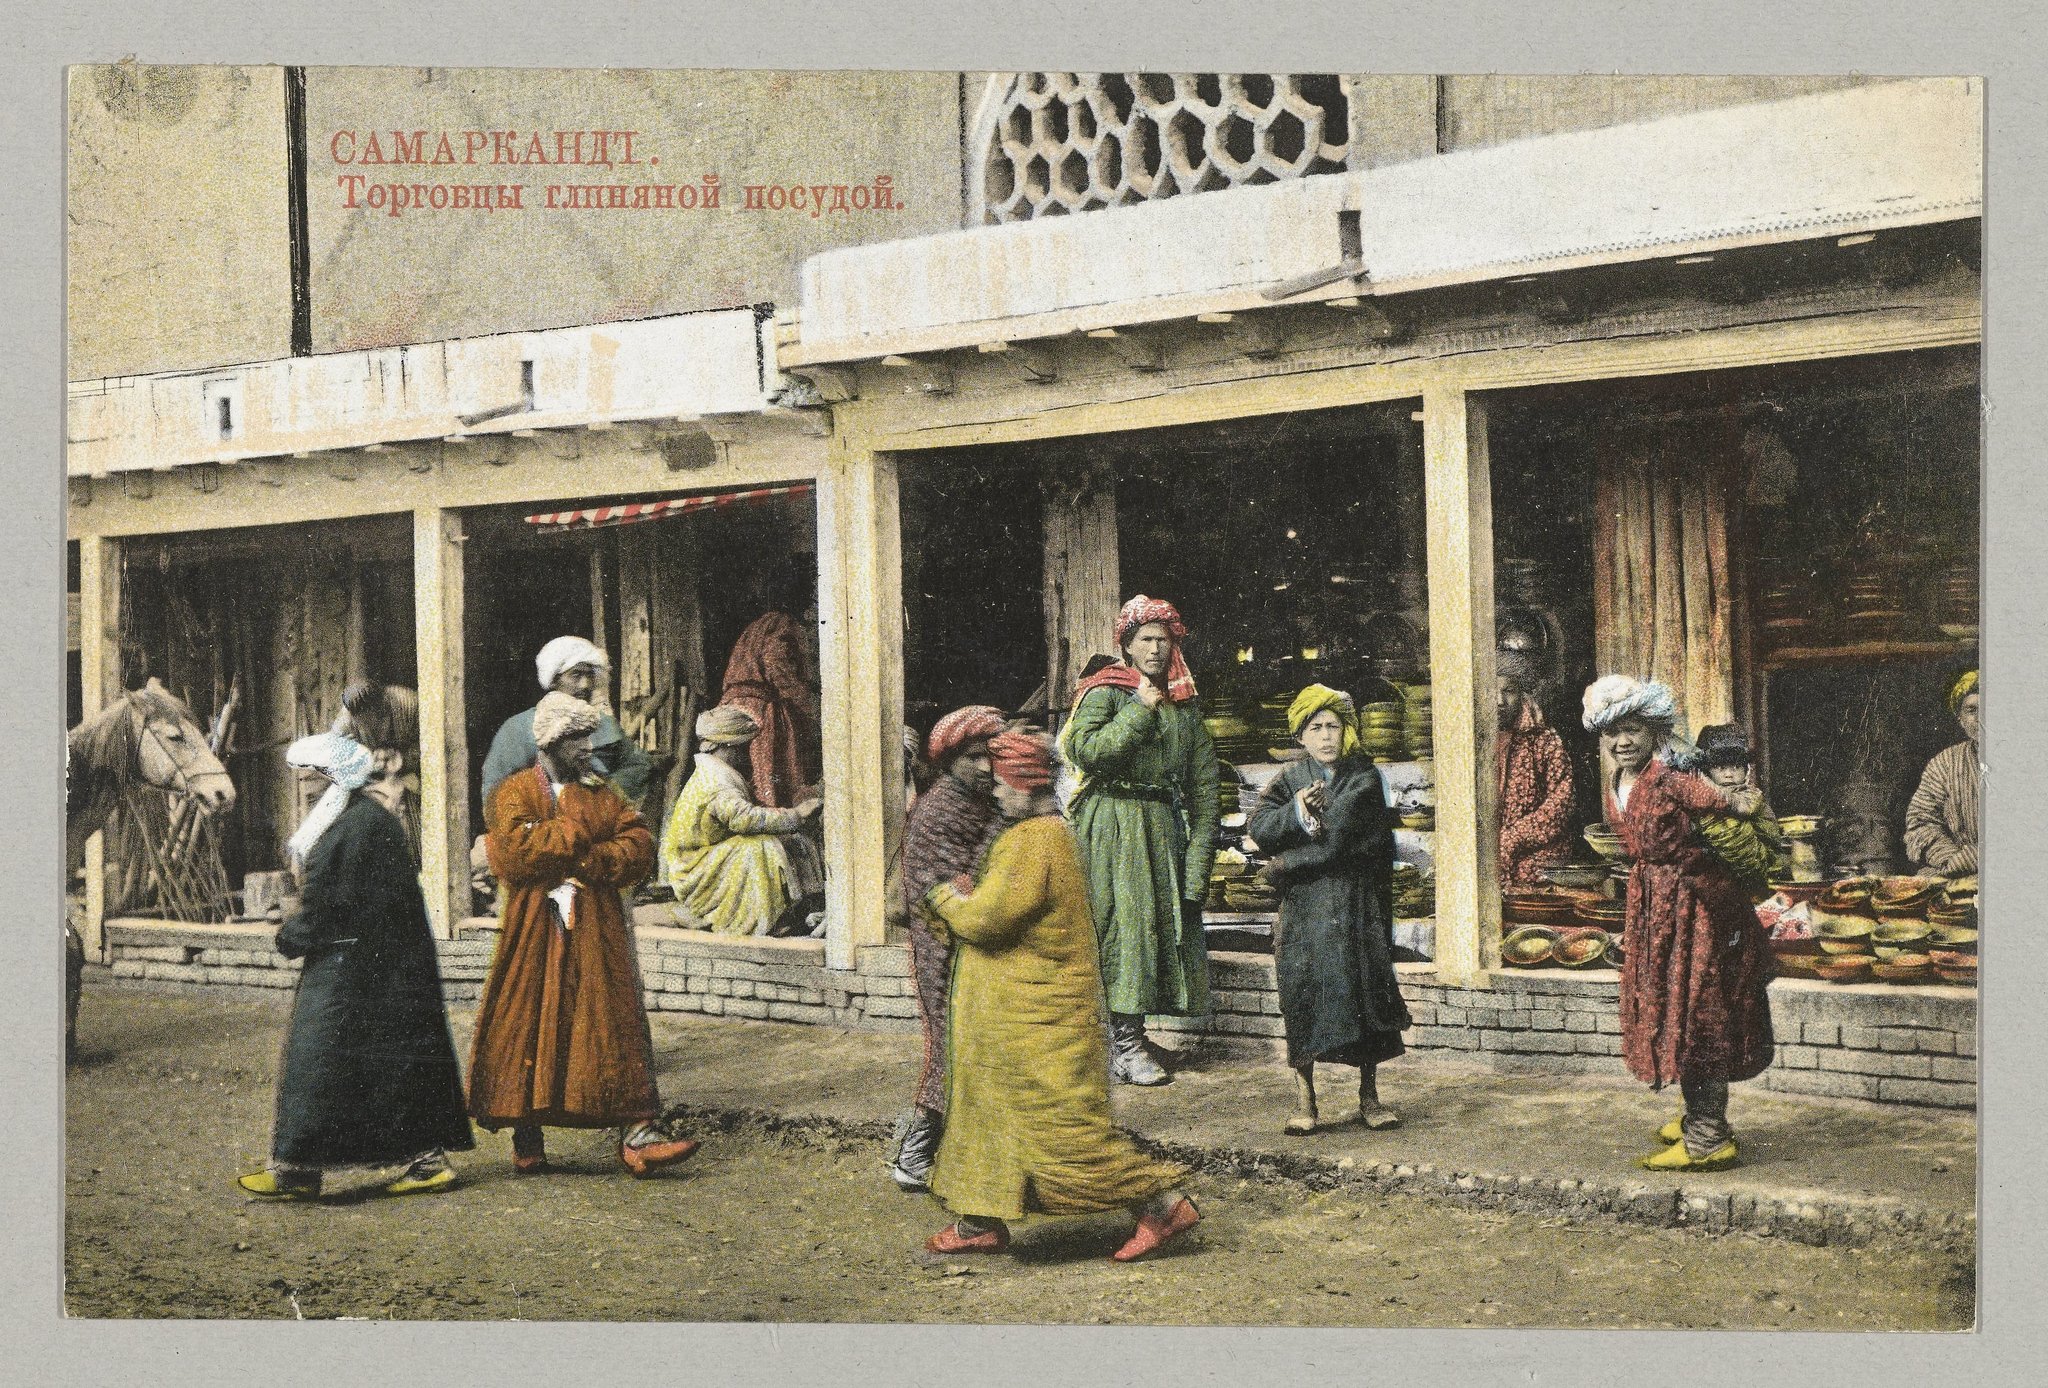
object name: ansichtkaart, prentbriefkaart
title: Straat met Oezbeken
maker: Anonymous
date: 1895-1915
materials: cardboard, paper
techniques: photograph, lithograph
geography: samarqand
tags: samarqand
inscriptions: number: ‘23.’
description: Groep mensen op straat, bovenaan staat een titel in het Russisch.